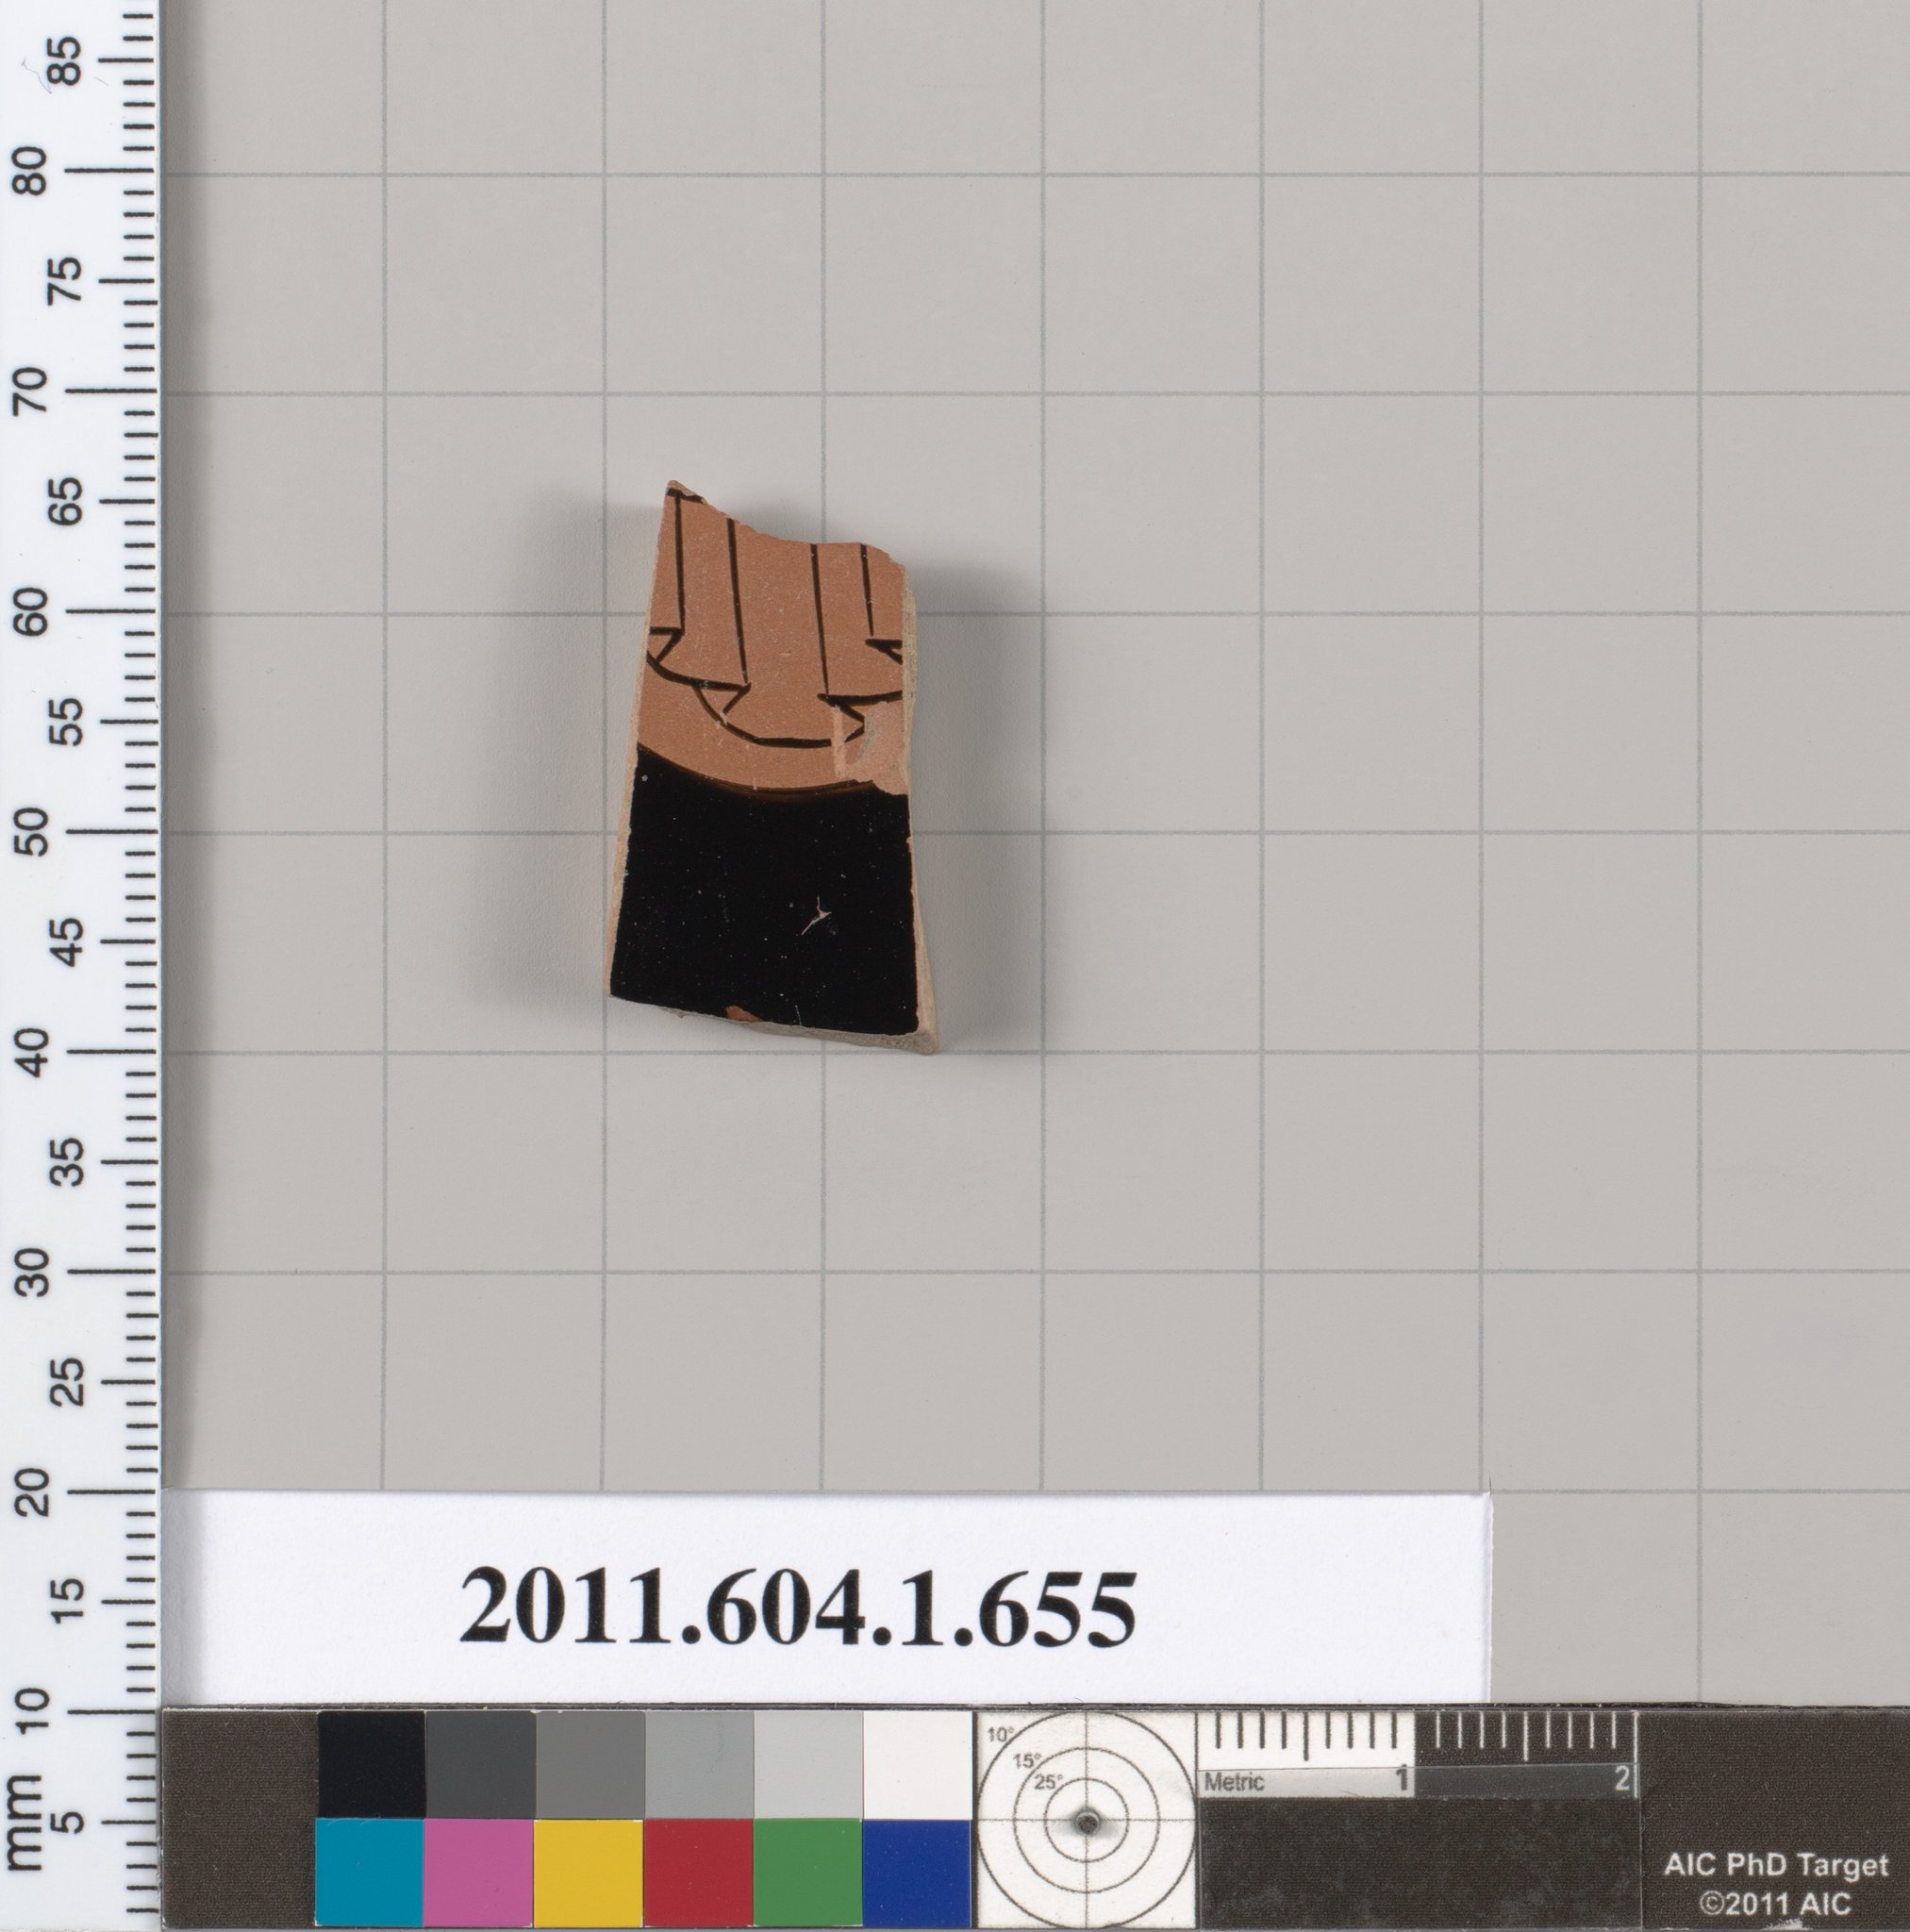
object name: kylix fragment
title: Terracotta fragment of a kylix (drinking cup)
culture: greek, attic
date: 475-451 BCE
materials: terracotta